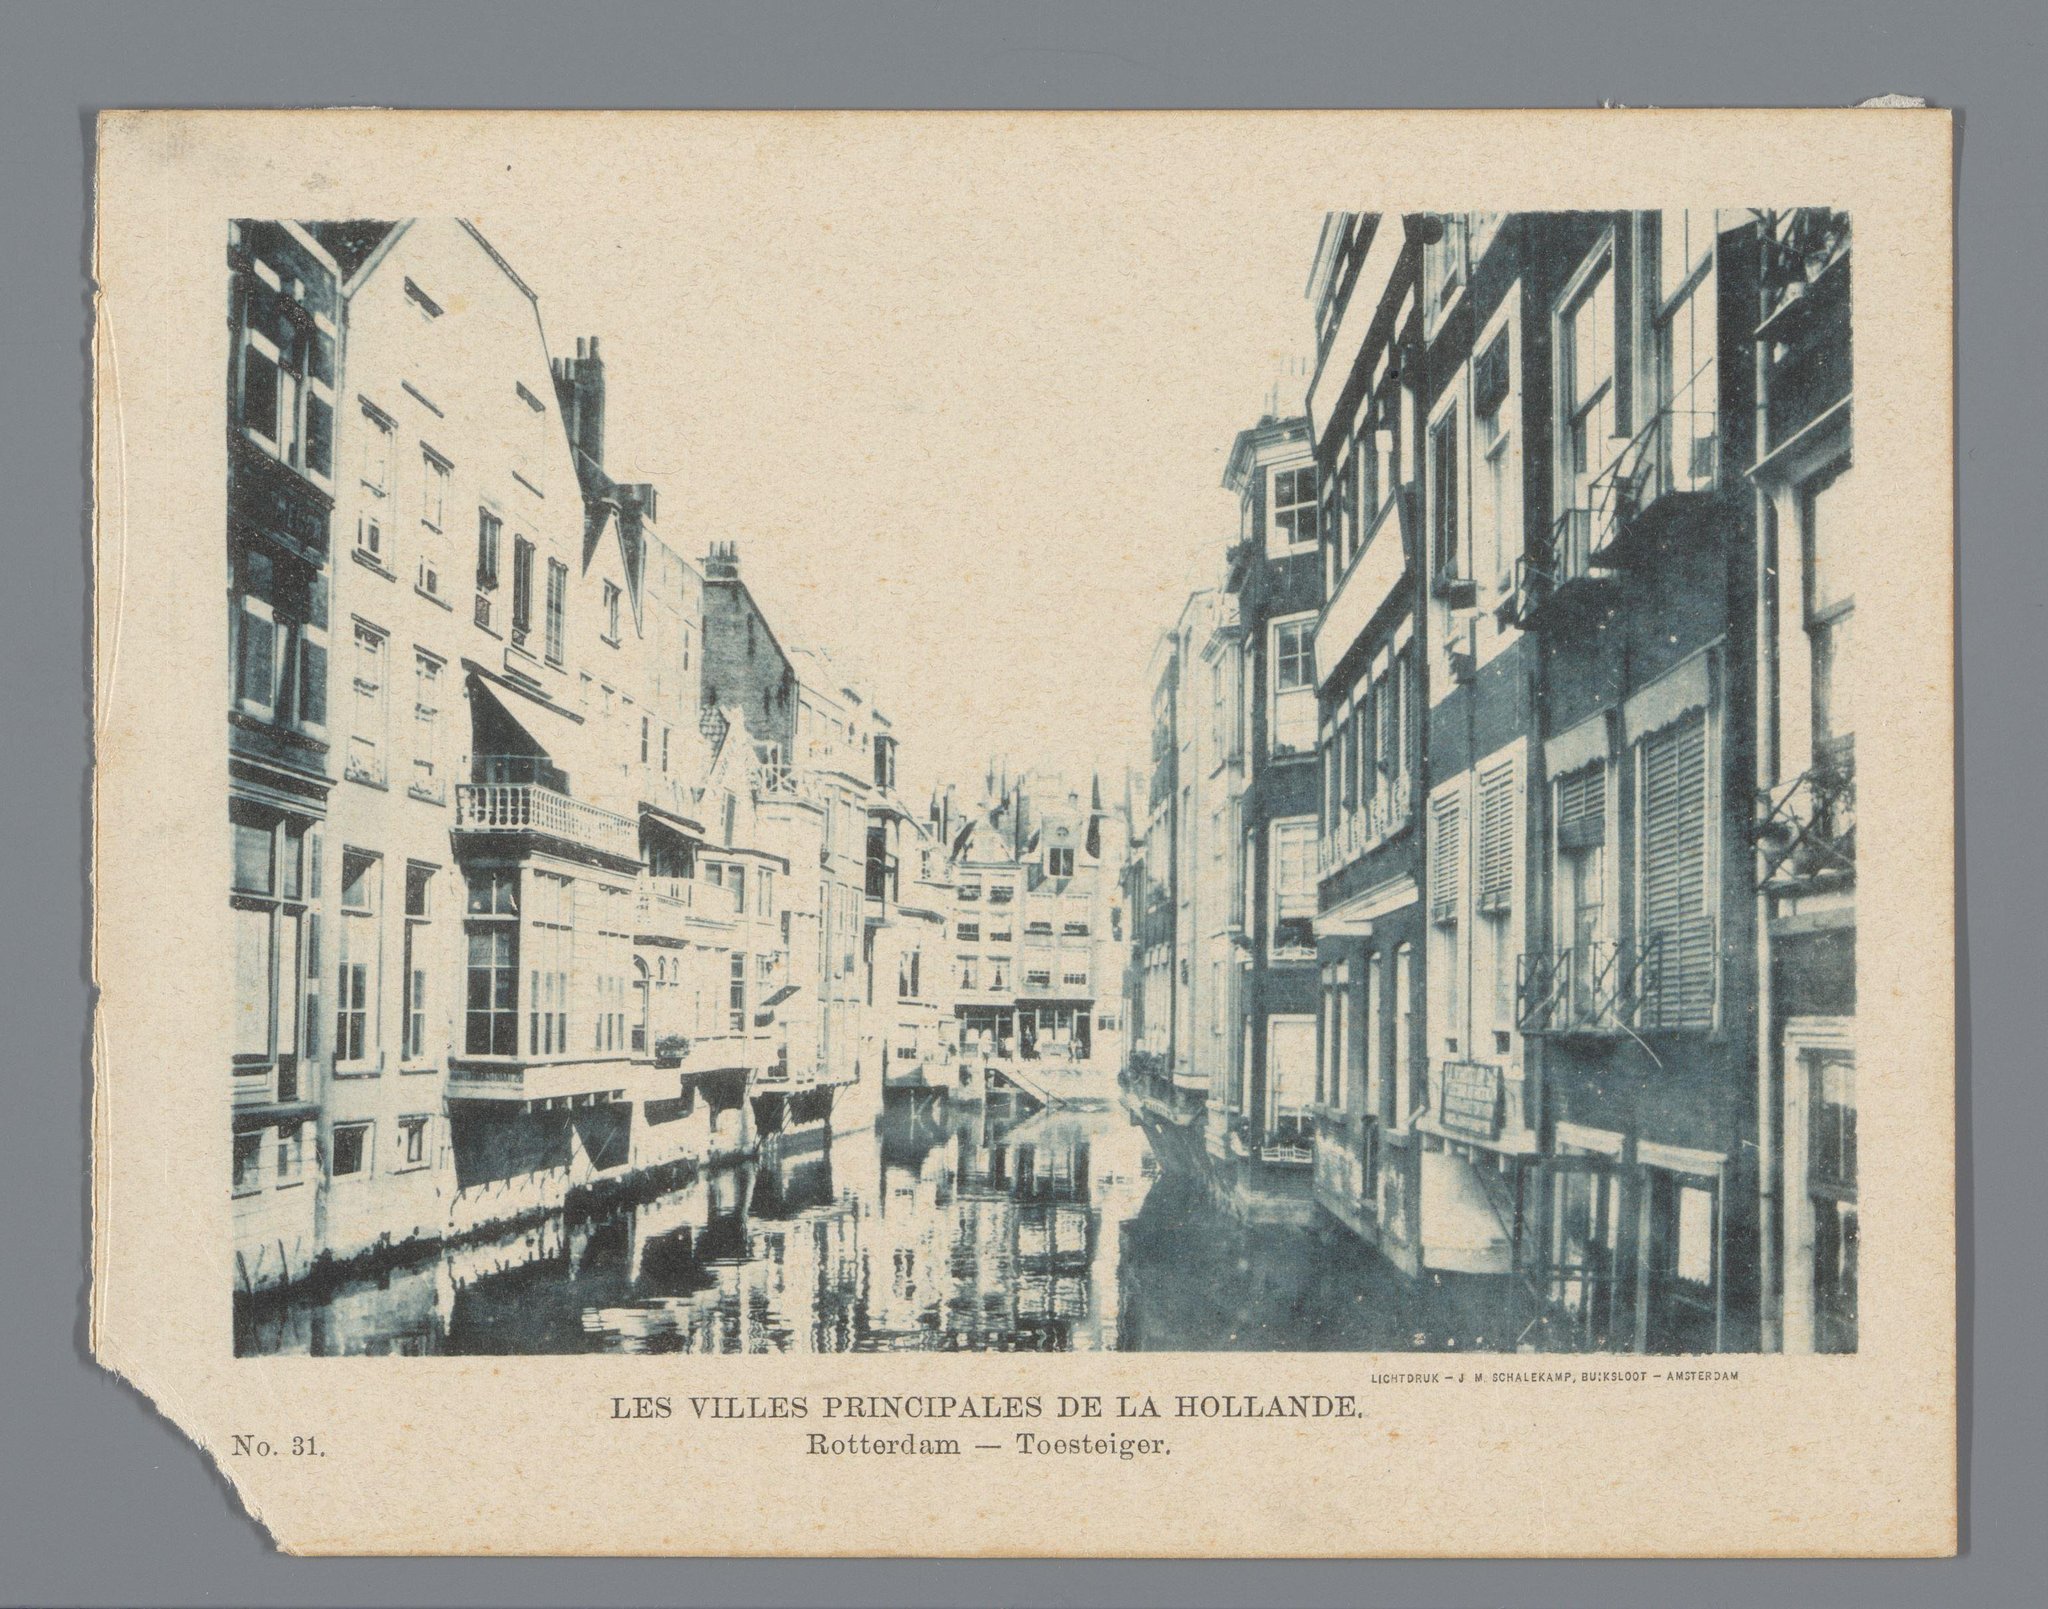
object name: photomechanical print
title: Les villes principales de la Hollande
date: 1875-1930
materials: paper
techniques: photograph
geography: buiksloot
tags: pier, quay, wharf, quay, rotterdam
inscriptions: collector's mark: Lugt 2228